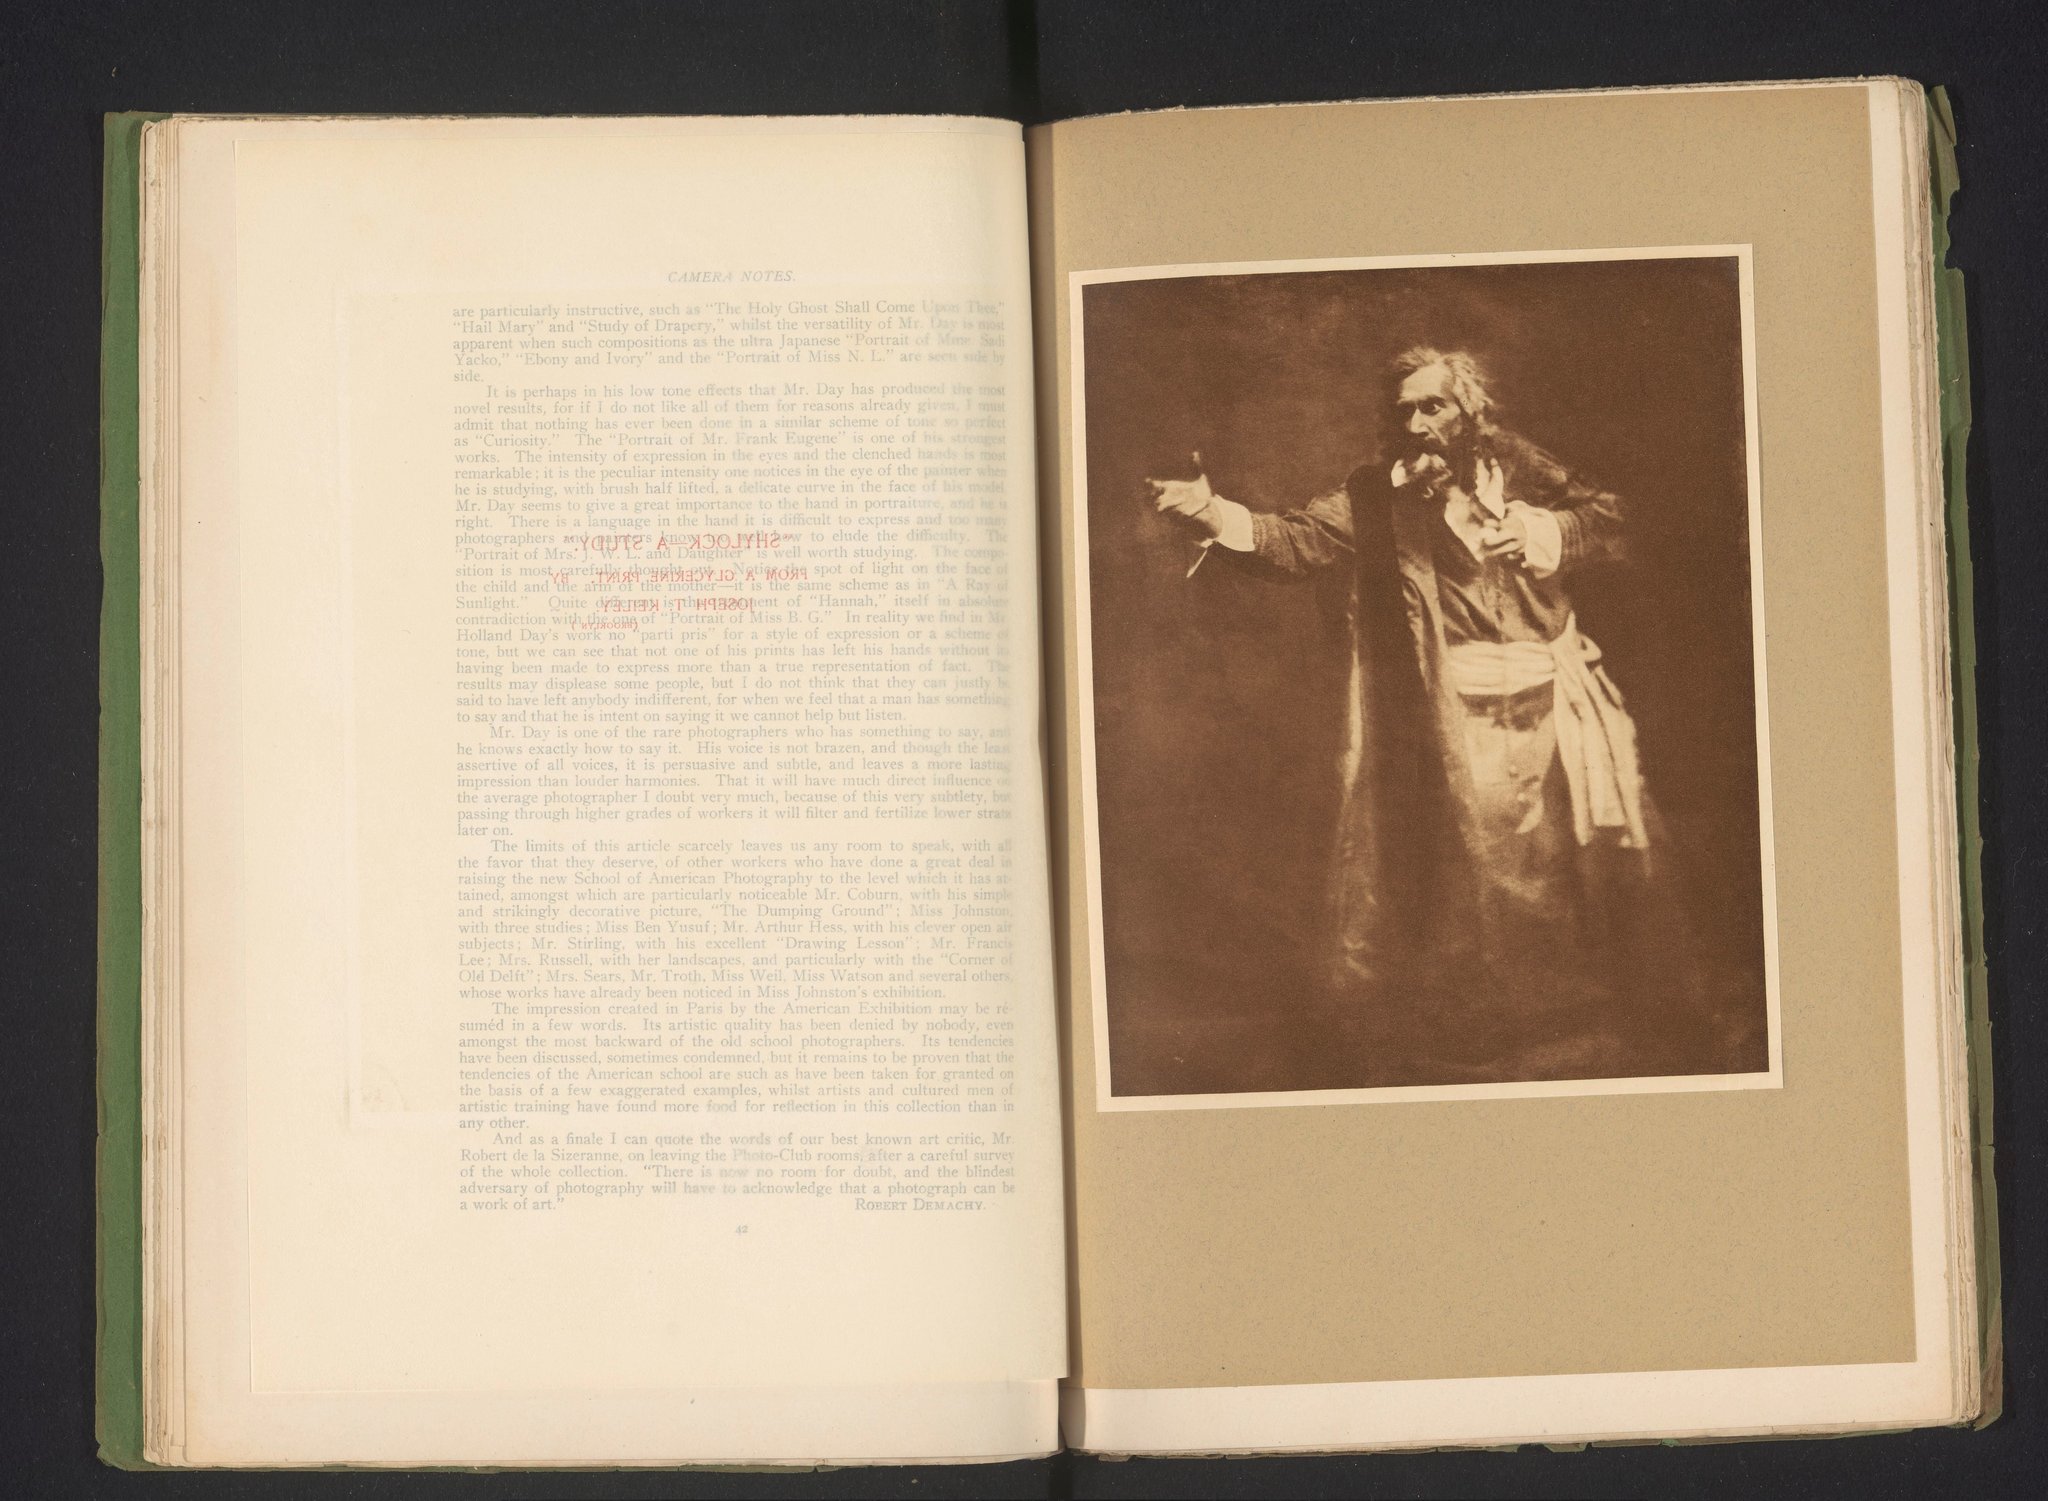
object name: photomechanical print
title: Portret van een onbekende acteur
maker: joseph turner keiley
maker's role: auteur, fotograaf, kunsthistoricus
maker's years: 1869-1914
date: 1896-1901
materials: paper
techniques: photoaquatint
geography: new york city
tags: actor (on the stage)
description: Prent tegenover pagina 42, achter semi-transparante omslag.